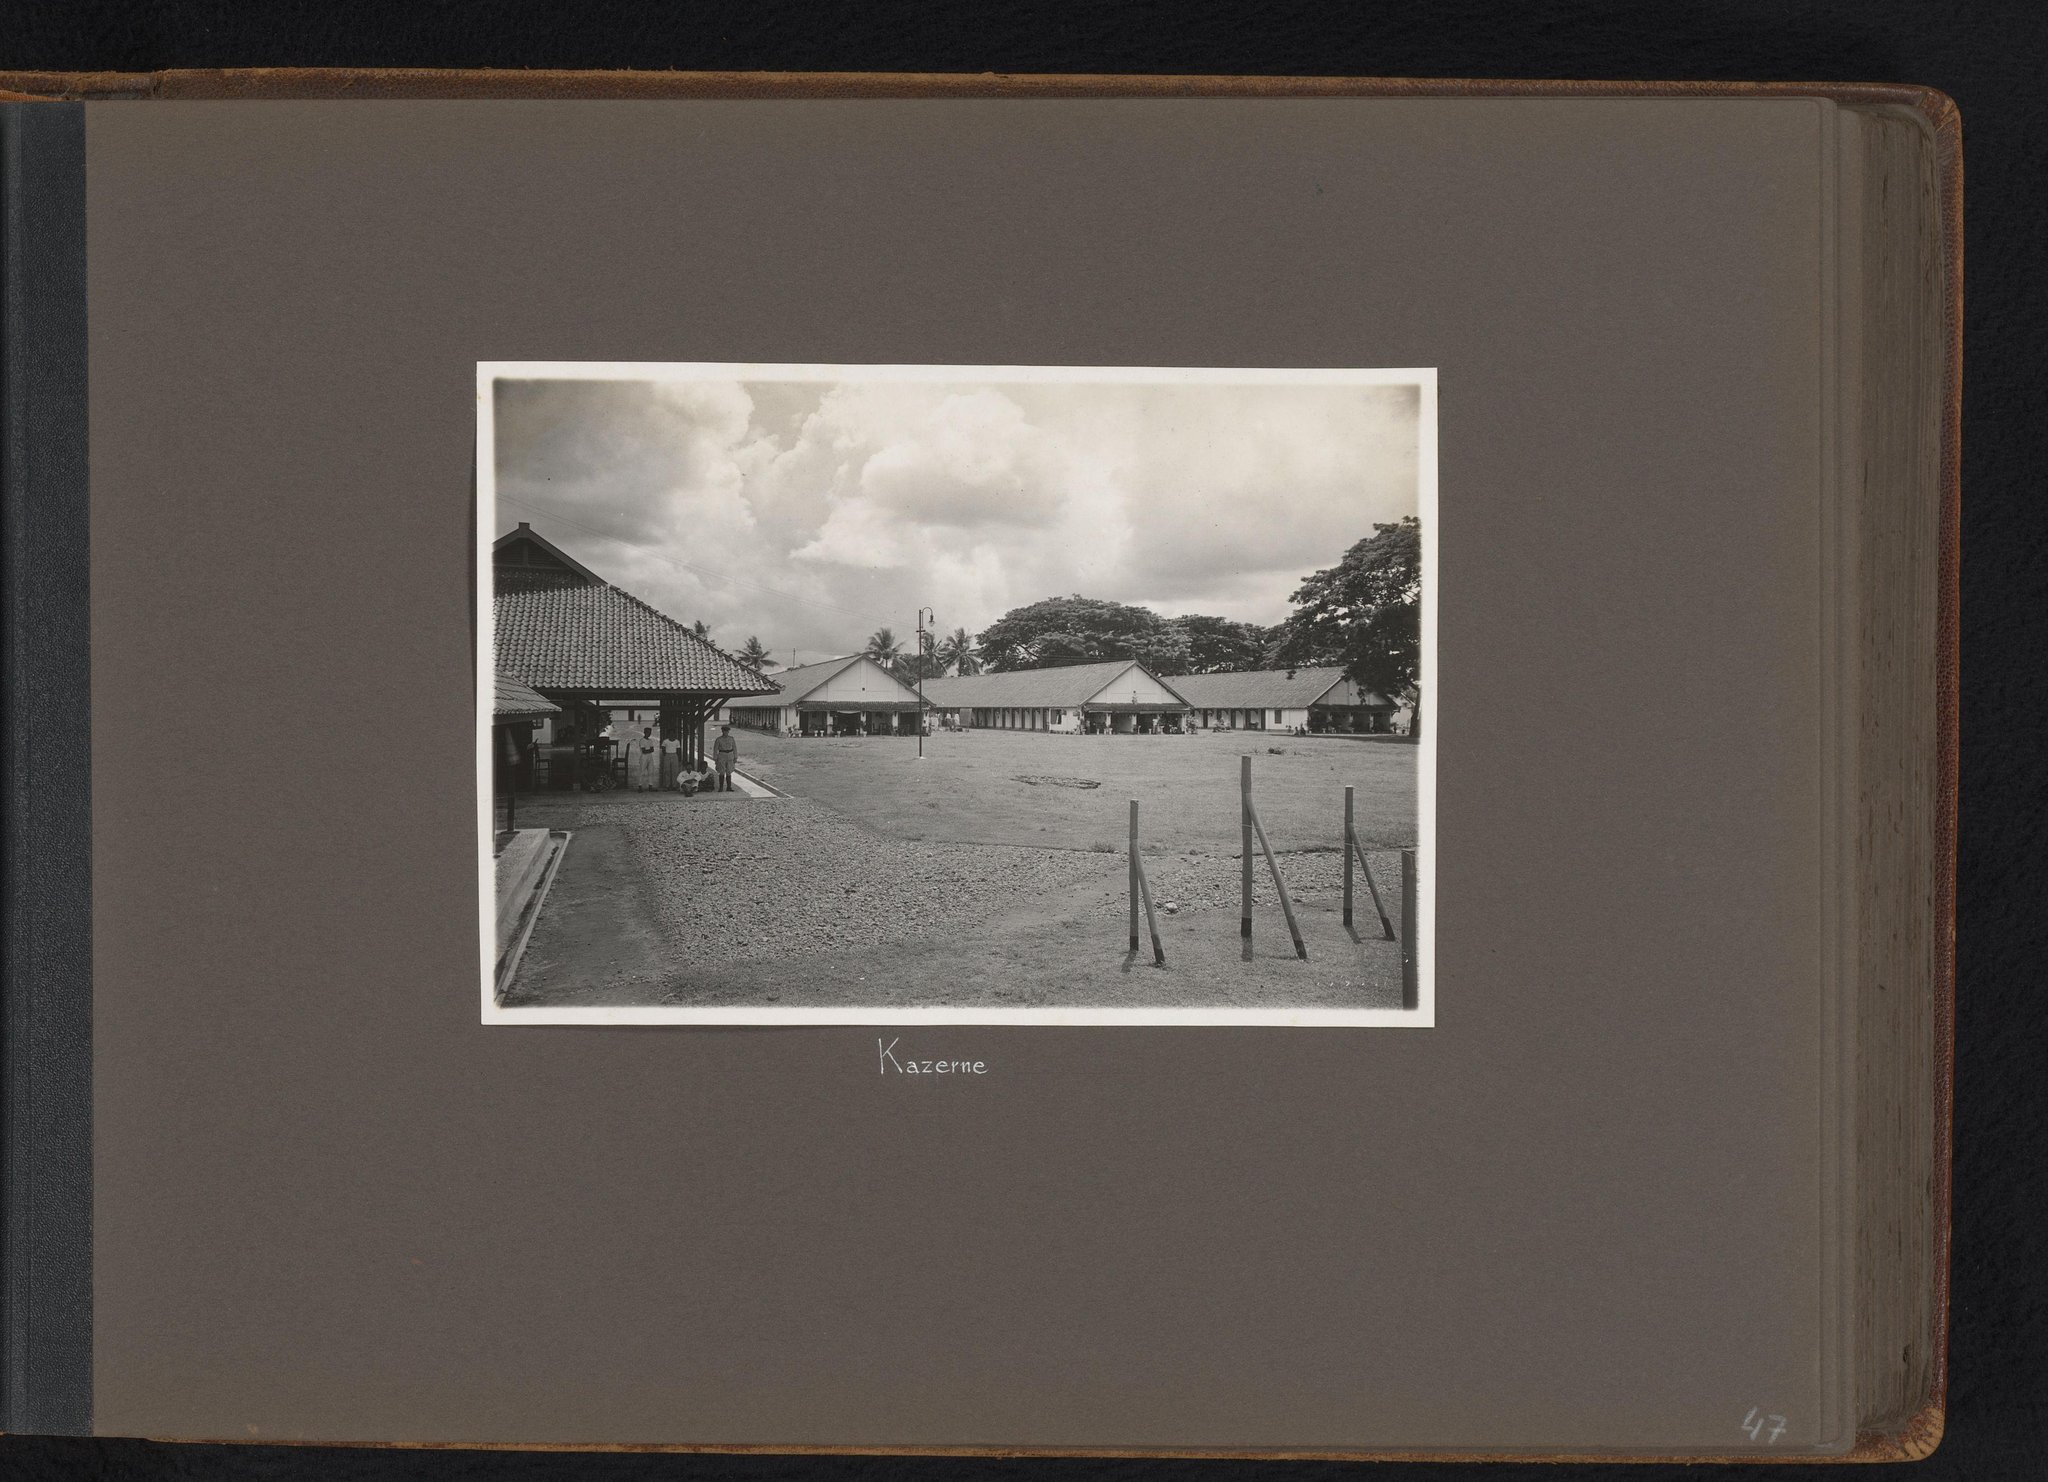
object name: photograph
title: Kazerne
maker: corn. weers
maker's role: fotograaf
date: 1925-1931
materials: cardboard, photographic support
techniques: gelatin silver print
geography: jogjakarta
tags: jogjakarta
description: Albumblad met één foto: kazerne van de politie te Jogyakarta. Onderdeel van het fotoalbum aangeboden aan S. Koster door de Vereeniging van Hoogere Politie Ambtenaren in Nederlandsch-Indië in 1931.